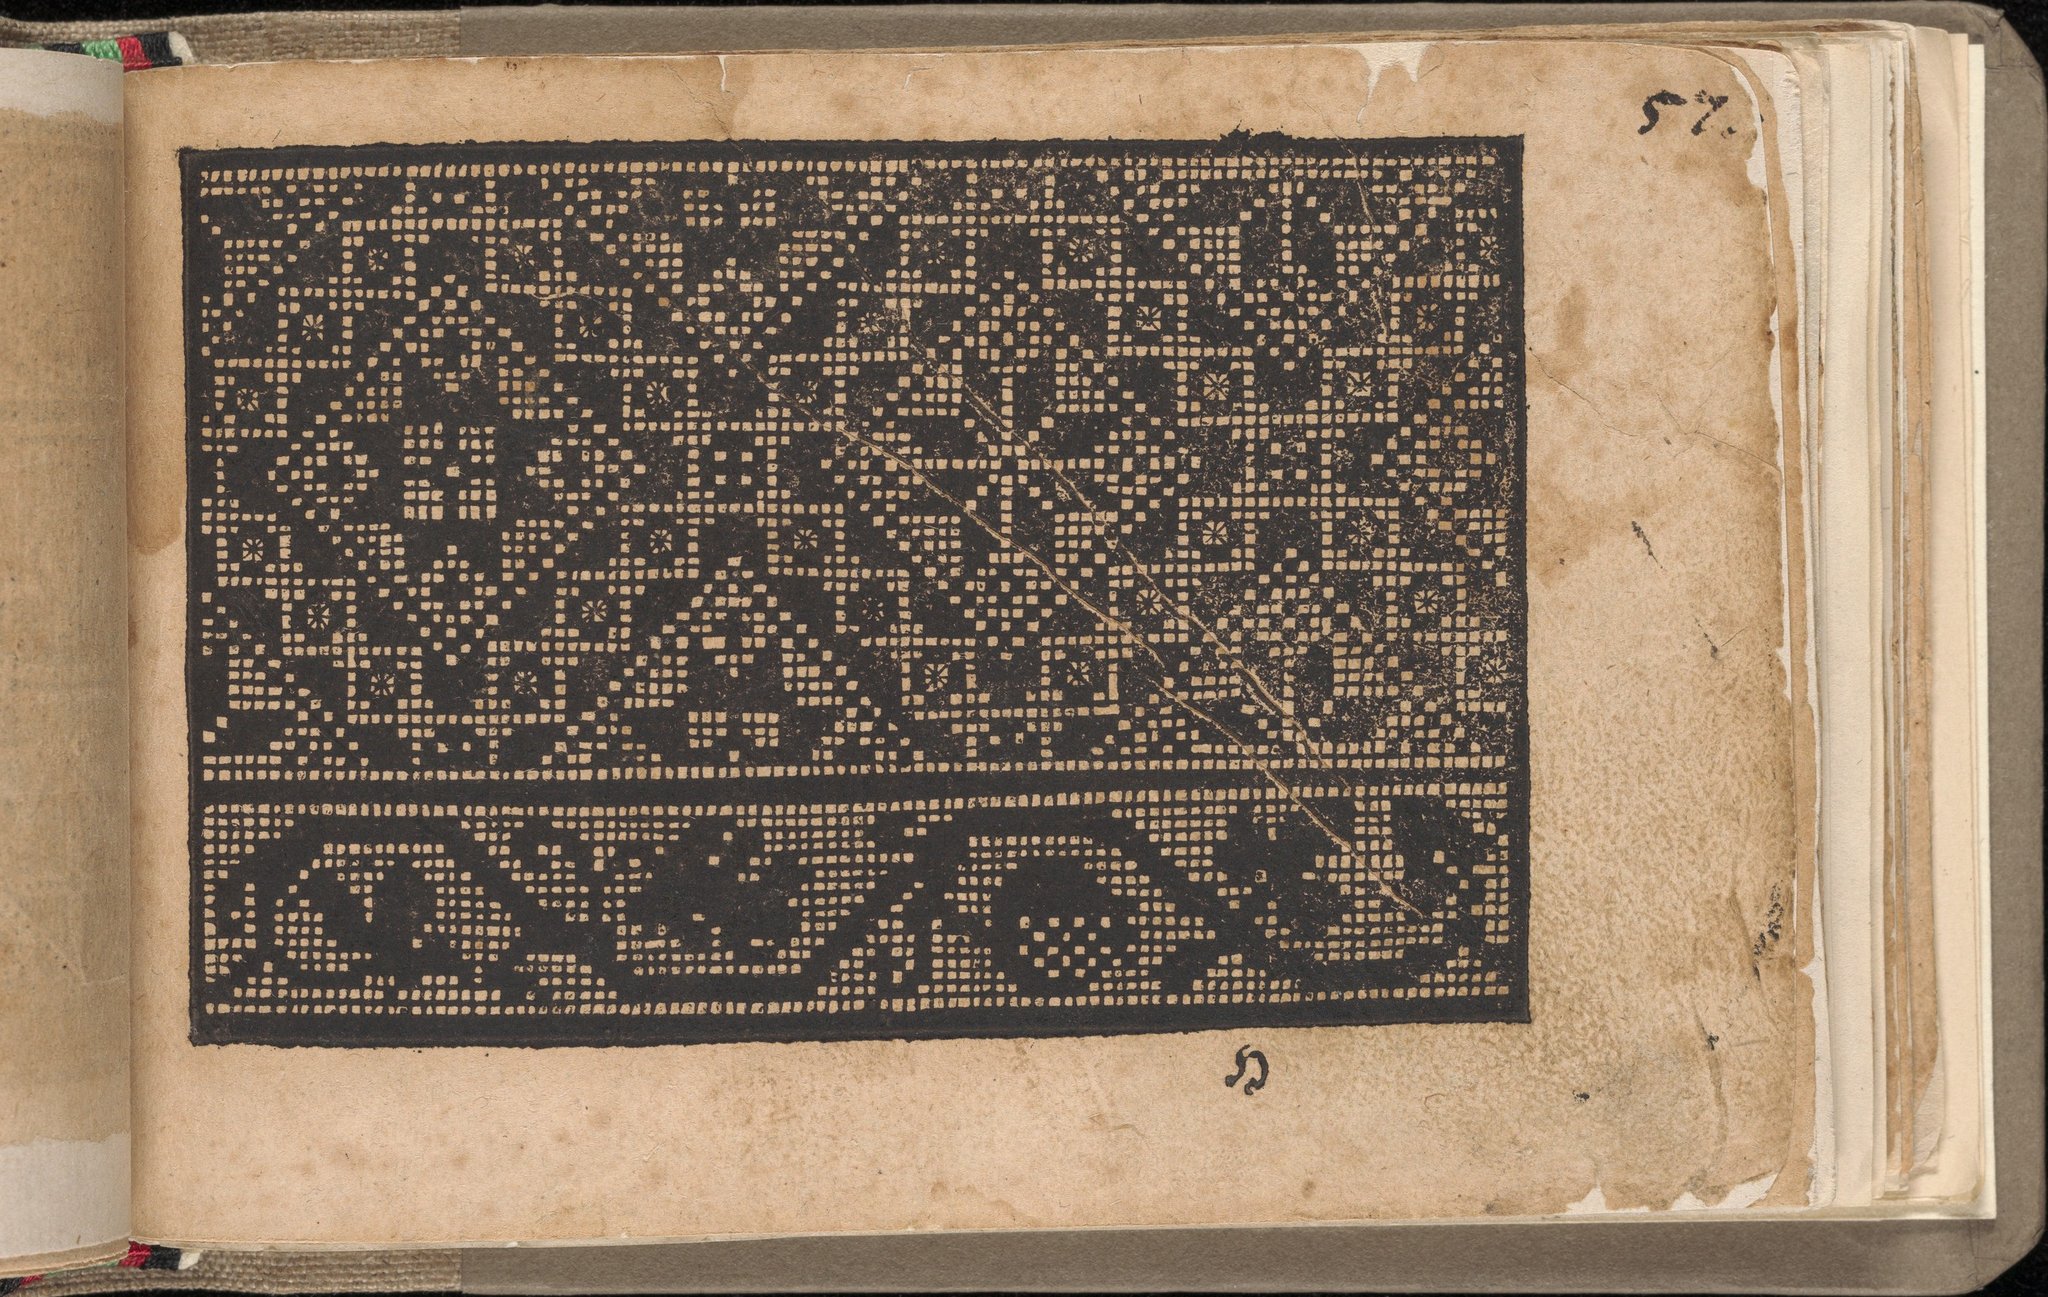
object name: book print ornament architecture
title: Schön newes Modelbuch (Page 57r)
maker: sigismundus latomus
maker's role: publisher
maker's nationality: german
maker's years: 1599-1632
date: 1608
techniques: woodcut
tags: ornament